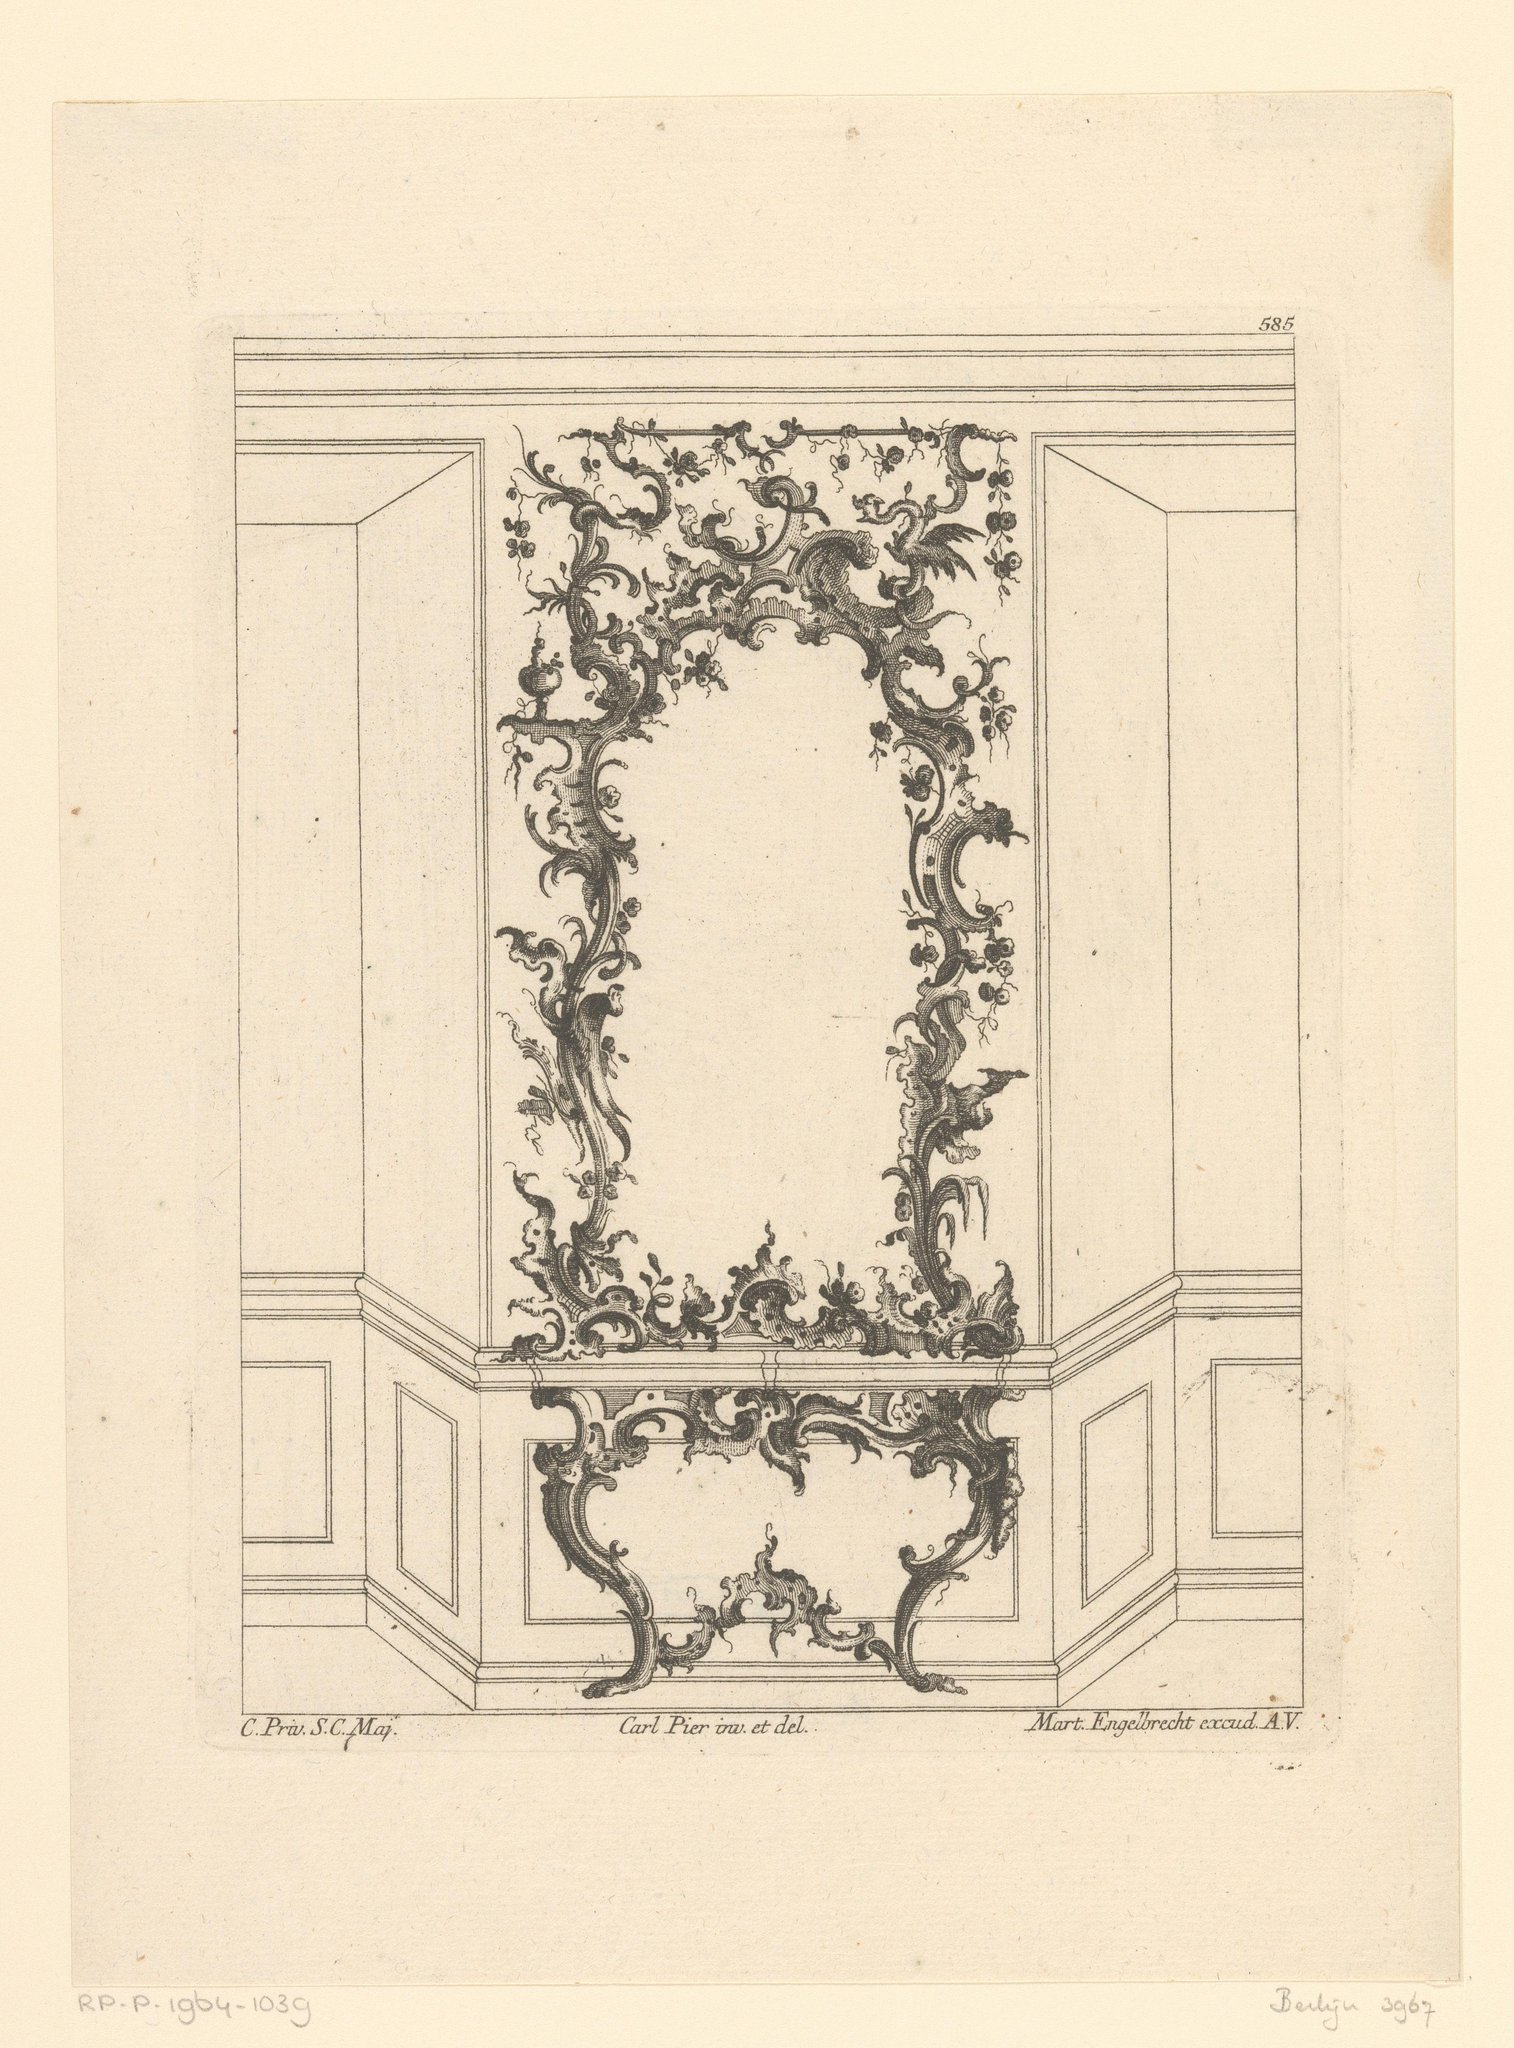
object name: ornament print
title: Wanddecoratie met nissen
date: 1748-1753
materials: paper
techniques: etching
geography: augsburg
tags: rocaille ornament, wall-covering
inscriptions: collector's mark: Lugt 2760, collector's mark: Lugt 2228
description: Ontwerp voor een rocaille wanddecoratie met bloemmotieven en nissen aan weerszijden. Prentnummer 585.